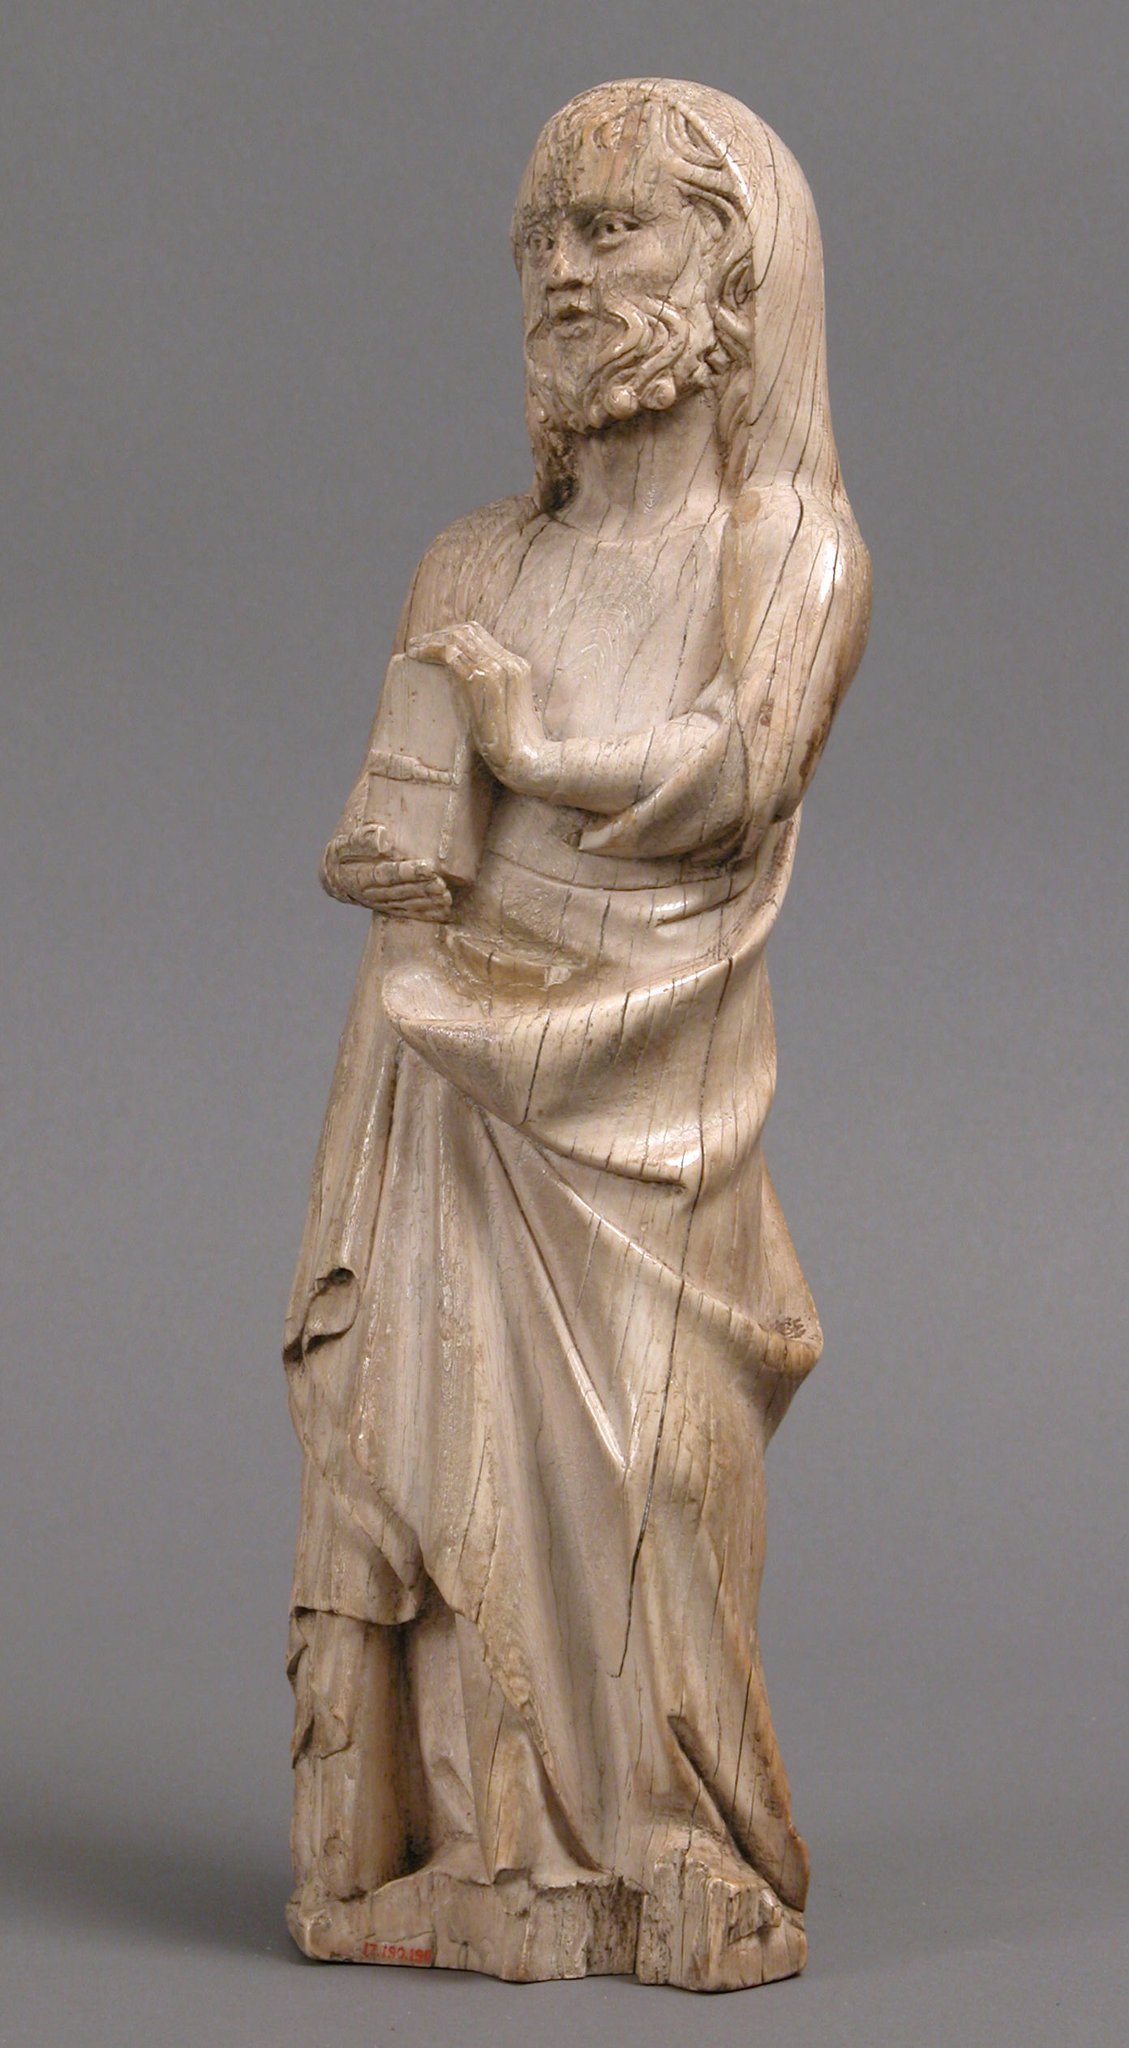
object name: relief statue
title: Apostle Holding a Book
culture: french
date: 1267-1300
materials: ivory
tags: books